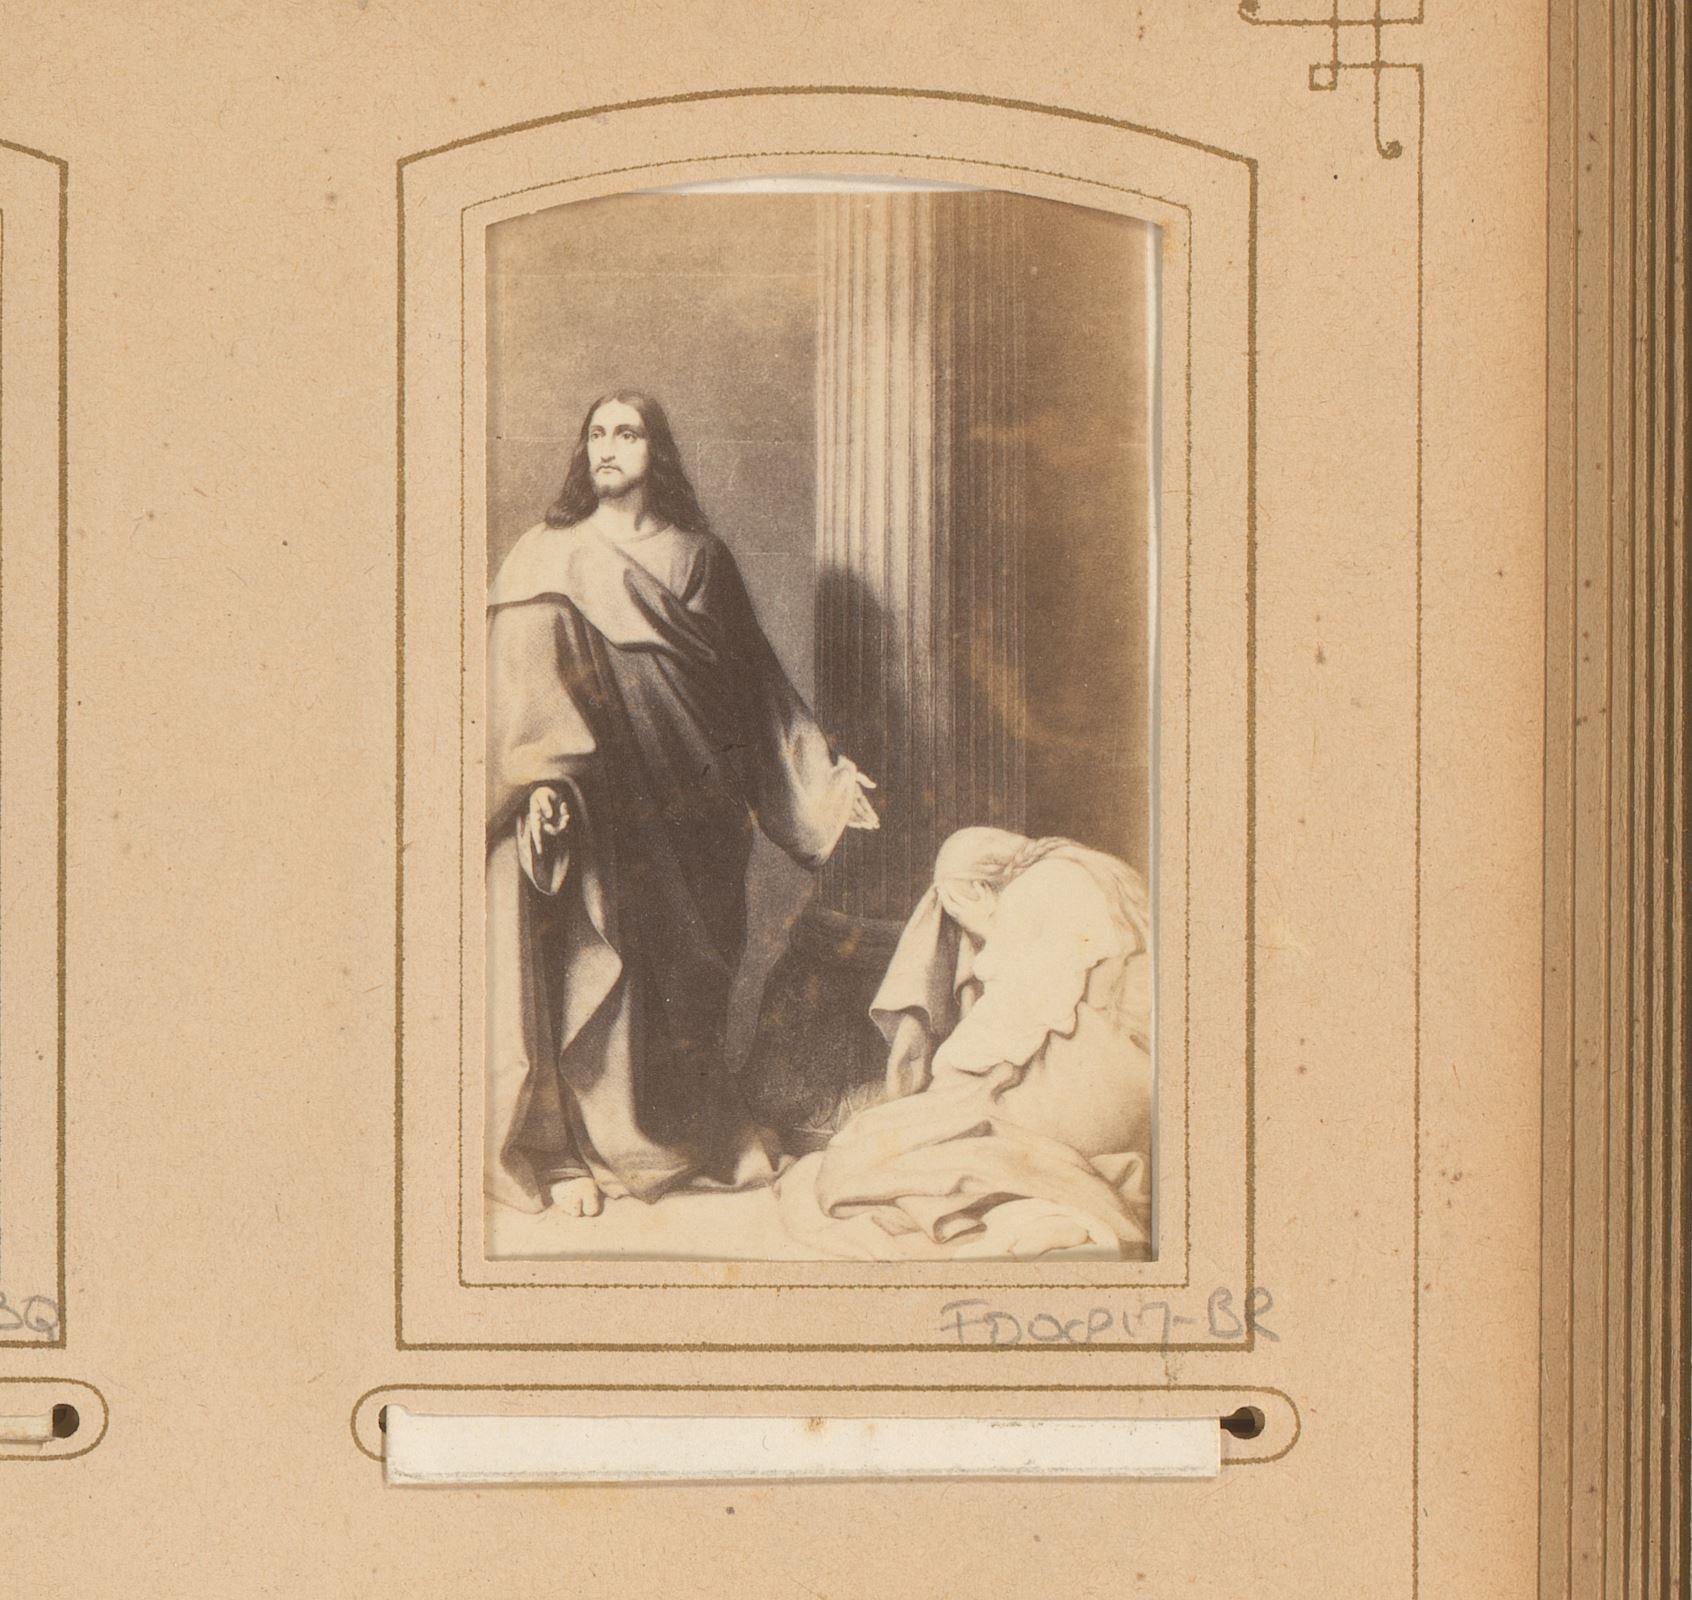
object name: album leaf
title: Fotoreproductie van een schilderij met Christus bij een vrouw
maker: Anonymous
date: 1860-1900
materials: cardboard, photographic support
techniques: albumen print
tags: pharisees bring a woman accused of adultery before christ (john 8:2-11)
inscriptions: annotation: ‘The good woman’